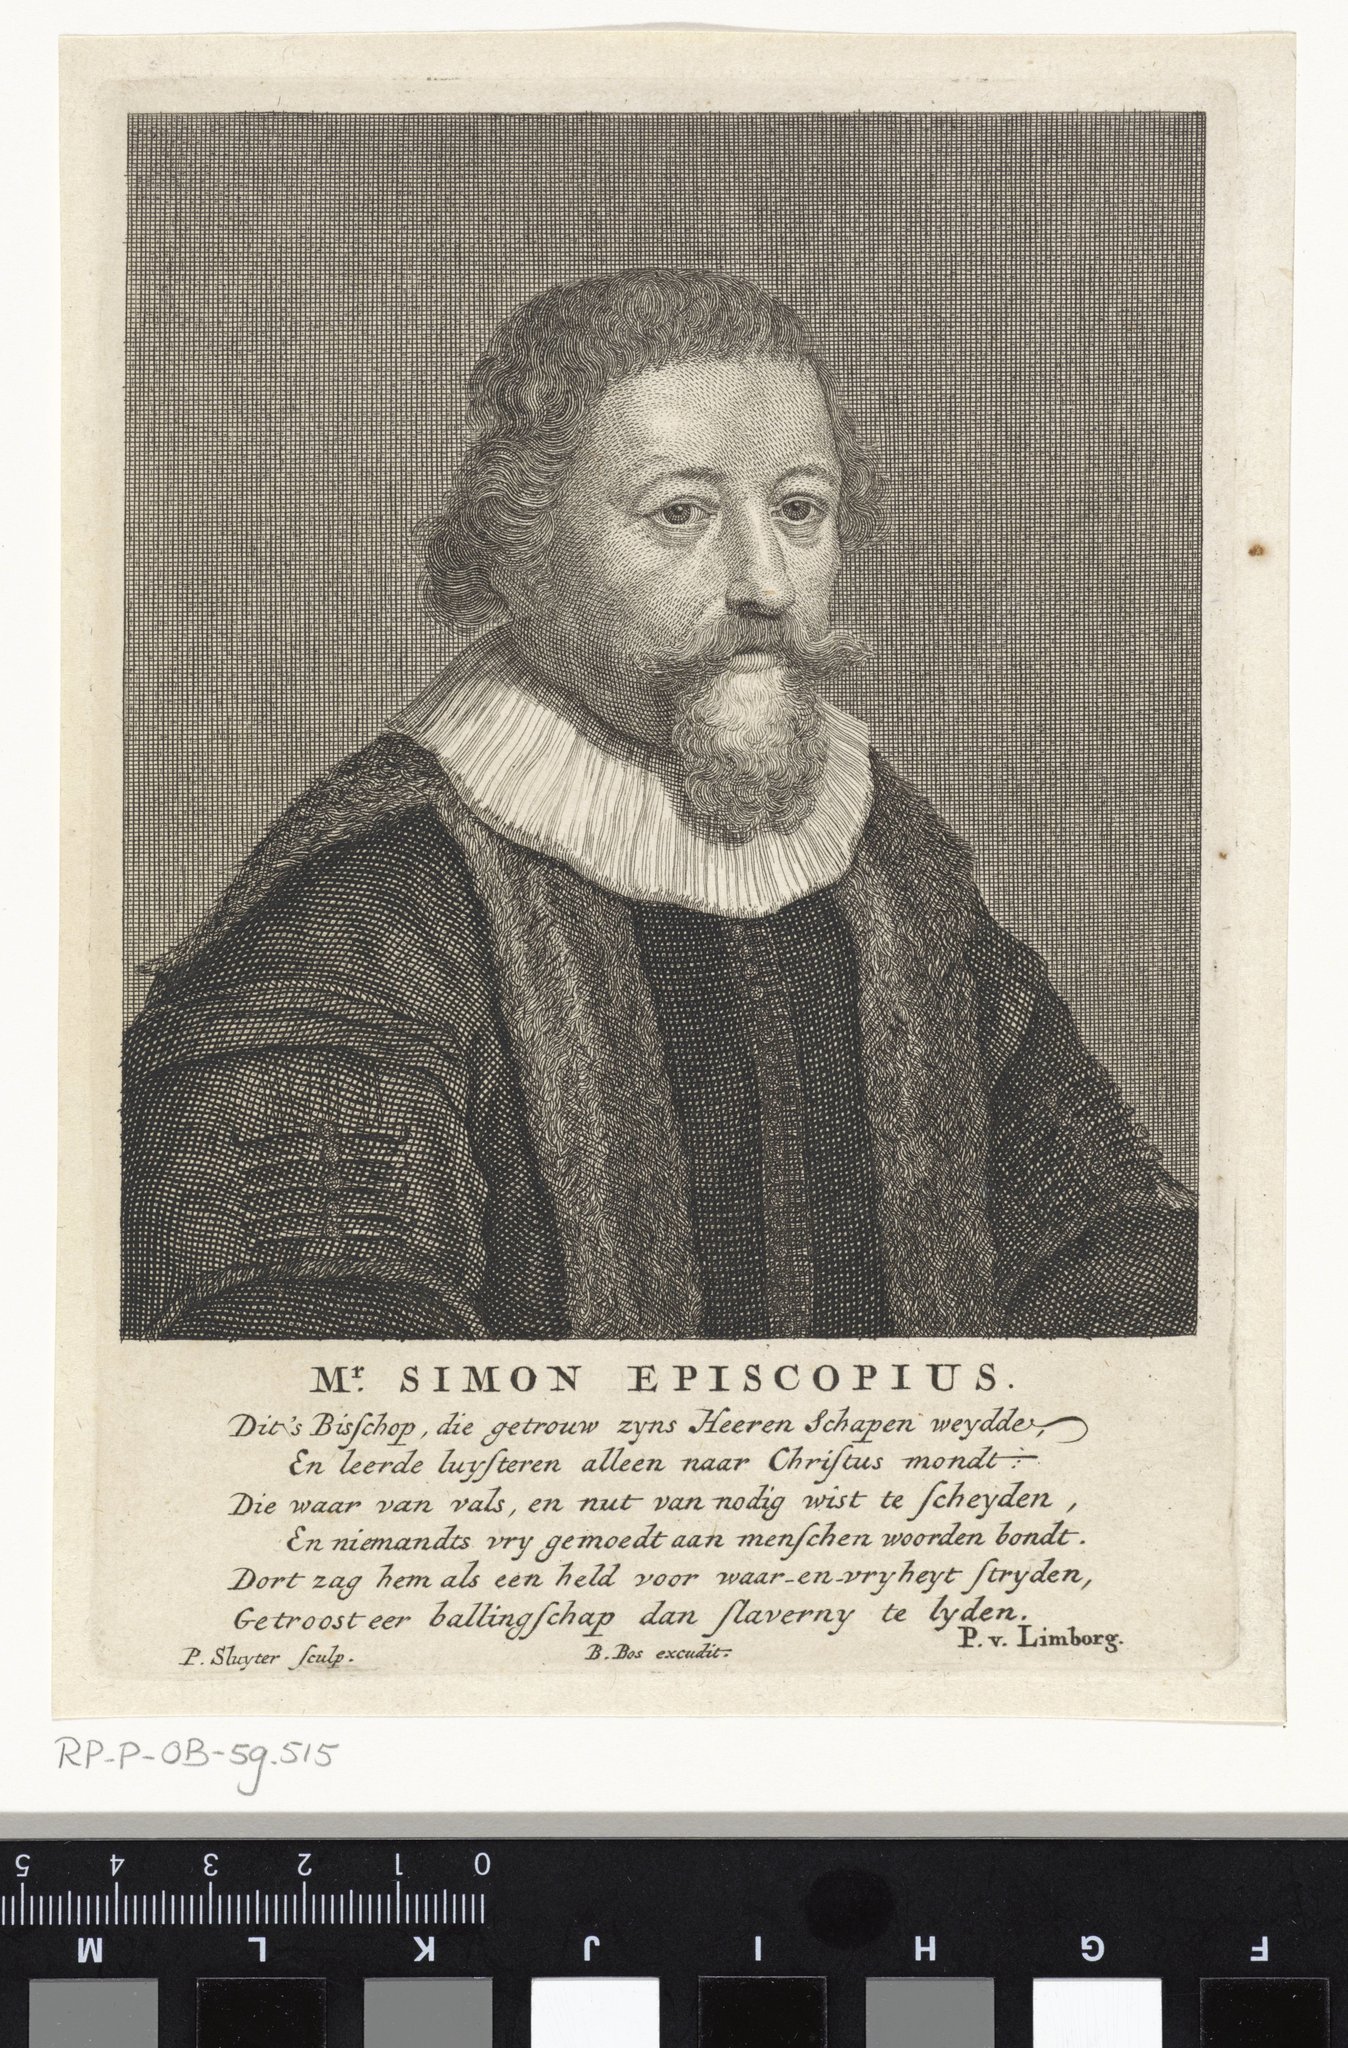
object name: print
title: Portret van Simon Bisschop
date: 1704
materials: paper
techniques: etching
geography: amsterdam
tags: theoloog, hoogleraar, simon bisschop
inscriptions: collector's mark: Lugt 2228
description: Prent ook gebruikt in: G. Brandts Historie der Reformatie, en andre kerkelyke geschiedenissen, in en ontrent de Nederlanden. Het derde deel. Rotterdam: Barent Bos, 1704, tussen p. 442 en 443.